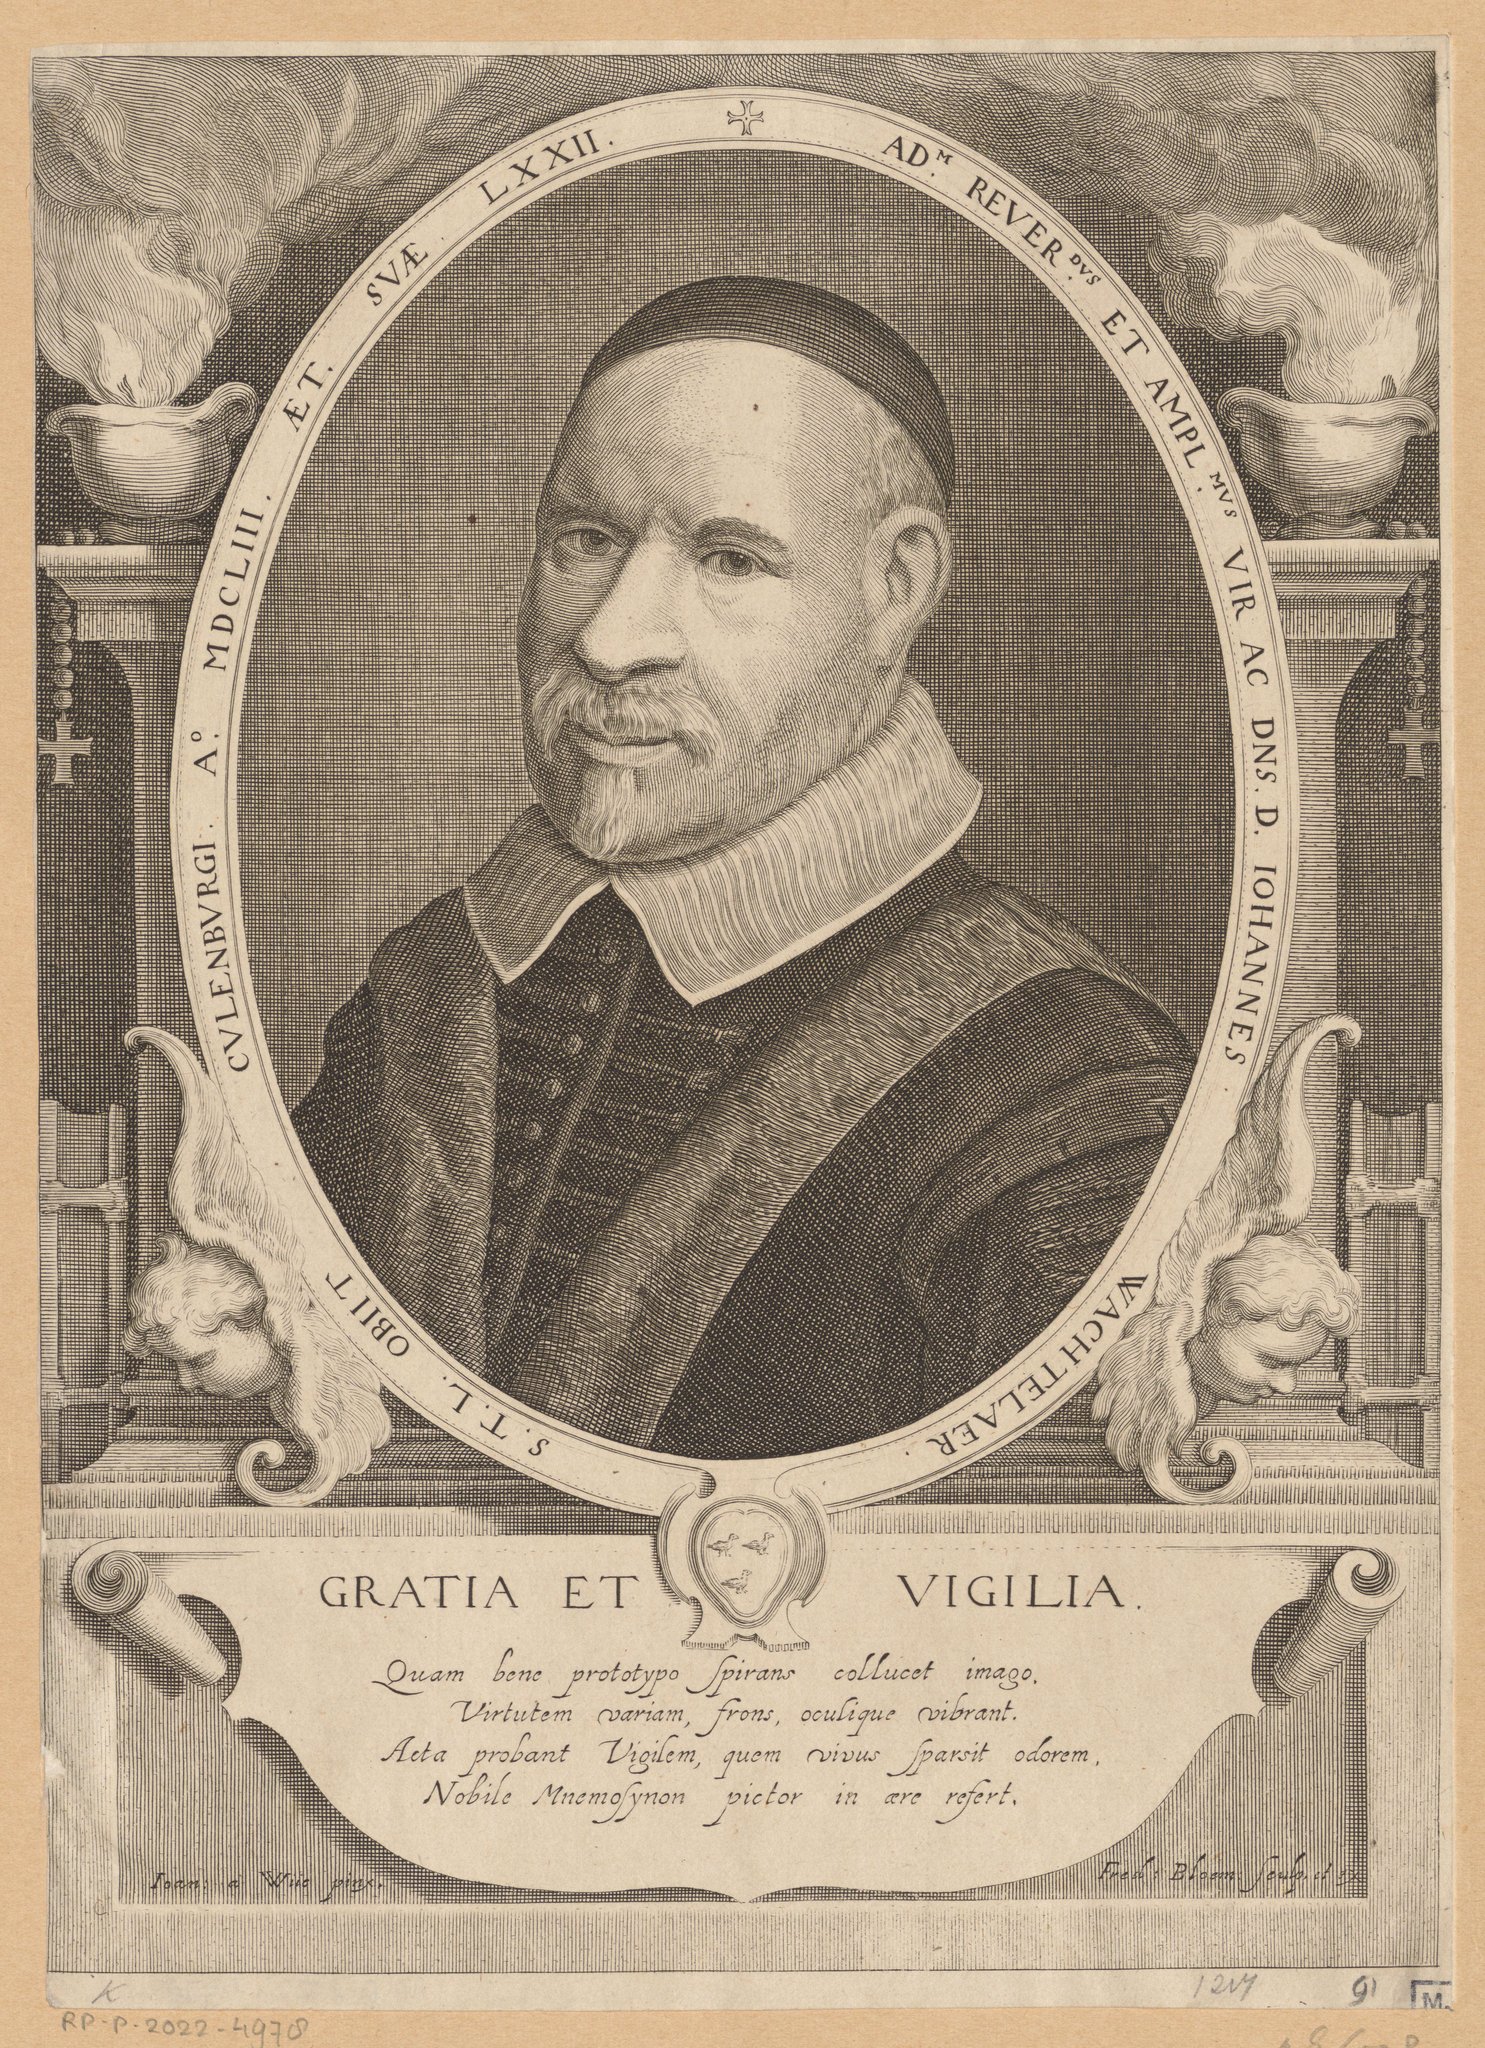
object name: print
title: Portret van Johannes Wachtelaer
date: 1653-1669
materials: paper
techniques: engraving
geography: utrecht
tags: cherubs, i.e. children's heads with wings, theologian, aids for prayer, e.g. rosary, historical persons, book, smoking pot as symbol of 'vanitas'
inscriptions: collector's mark: ‘M.’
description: Prent ook gebruikt in: ook gebruikt in: Heussen, Hugo Franciscus, Hendrik van Rijn. Kerkelijke historie en outheden der zeven Vereenigde Provincien (...). Leiden: Dirk Haak, Samuel Luchtmans en Johannes Arnoldus Langerak, 1726, dl. 2.